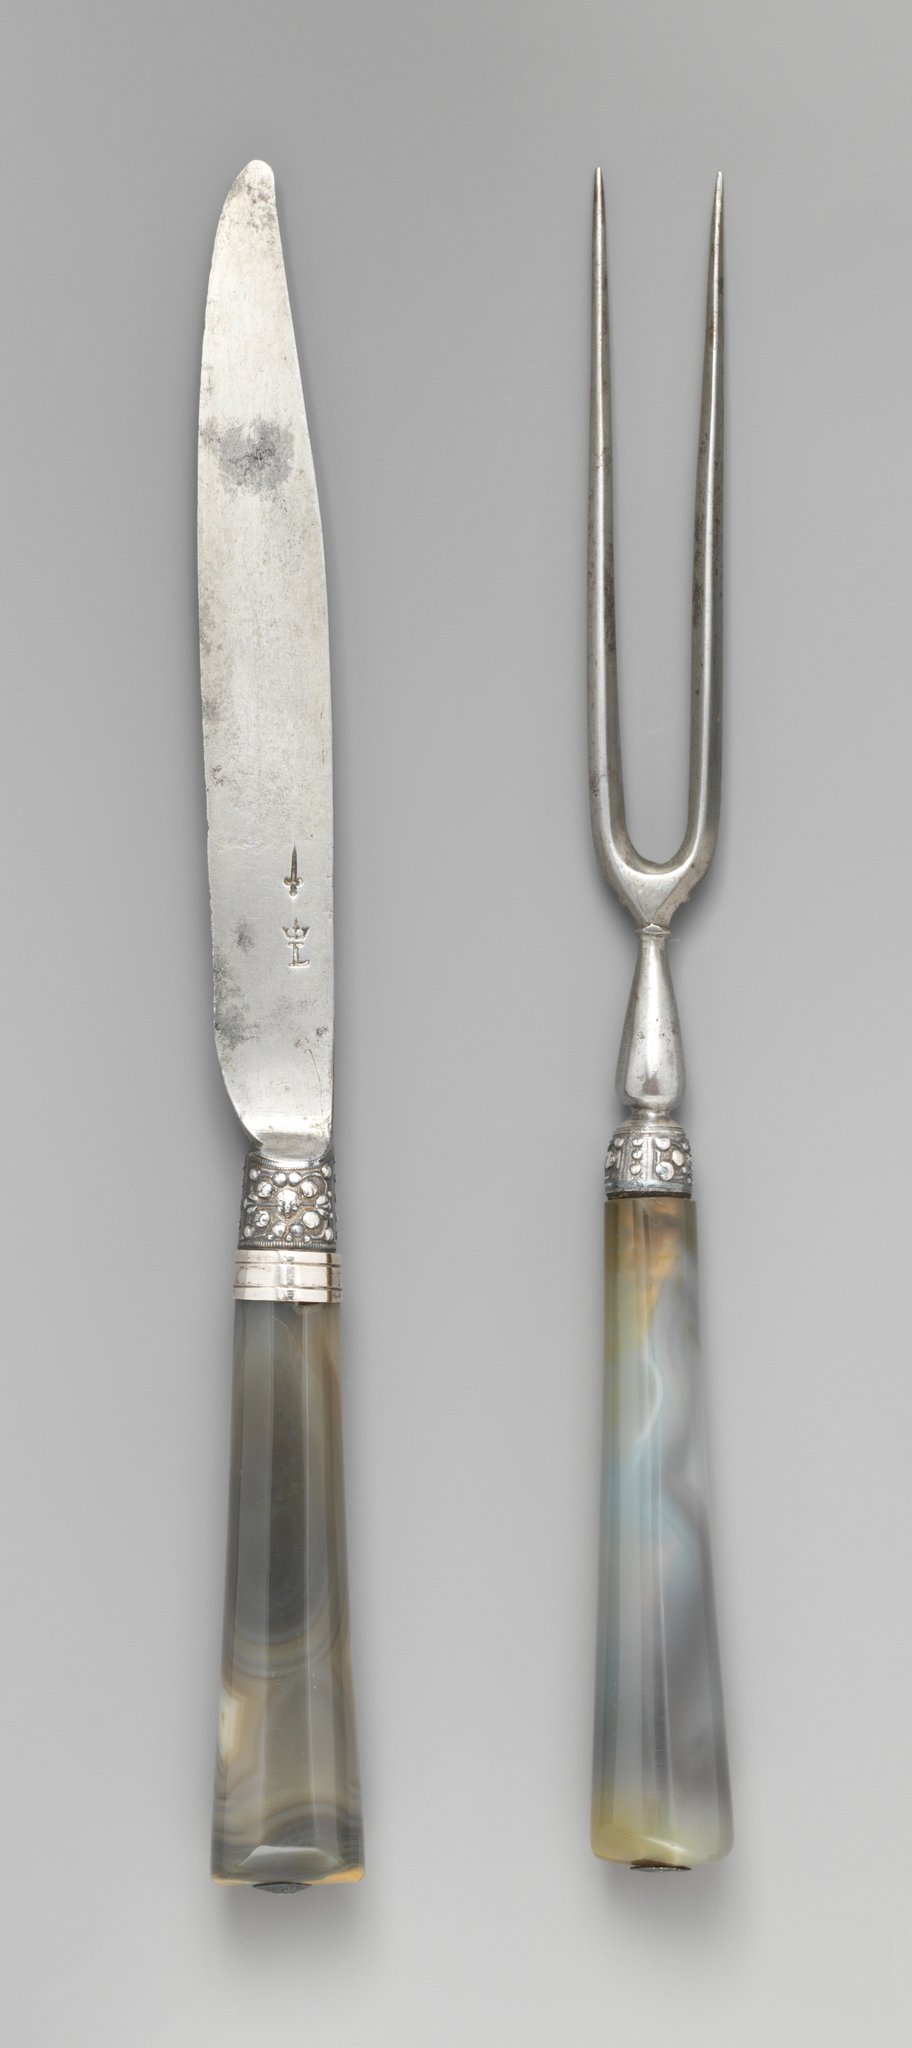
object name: table knife and fork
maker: william laughton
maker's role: maker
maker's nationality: british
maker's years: 1626-1726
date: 1601-1700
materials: stone, silver, steel